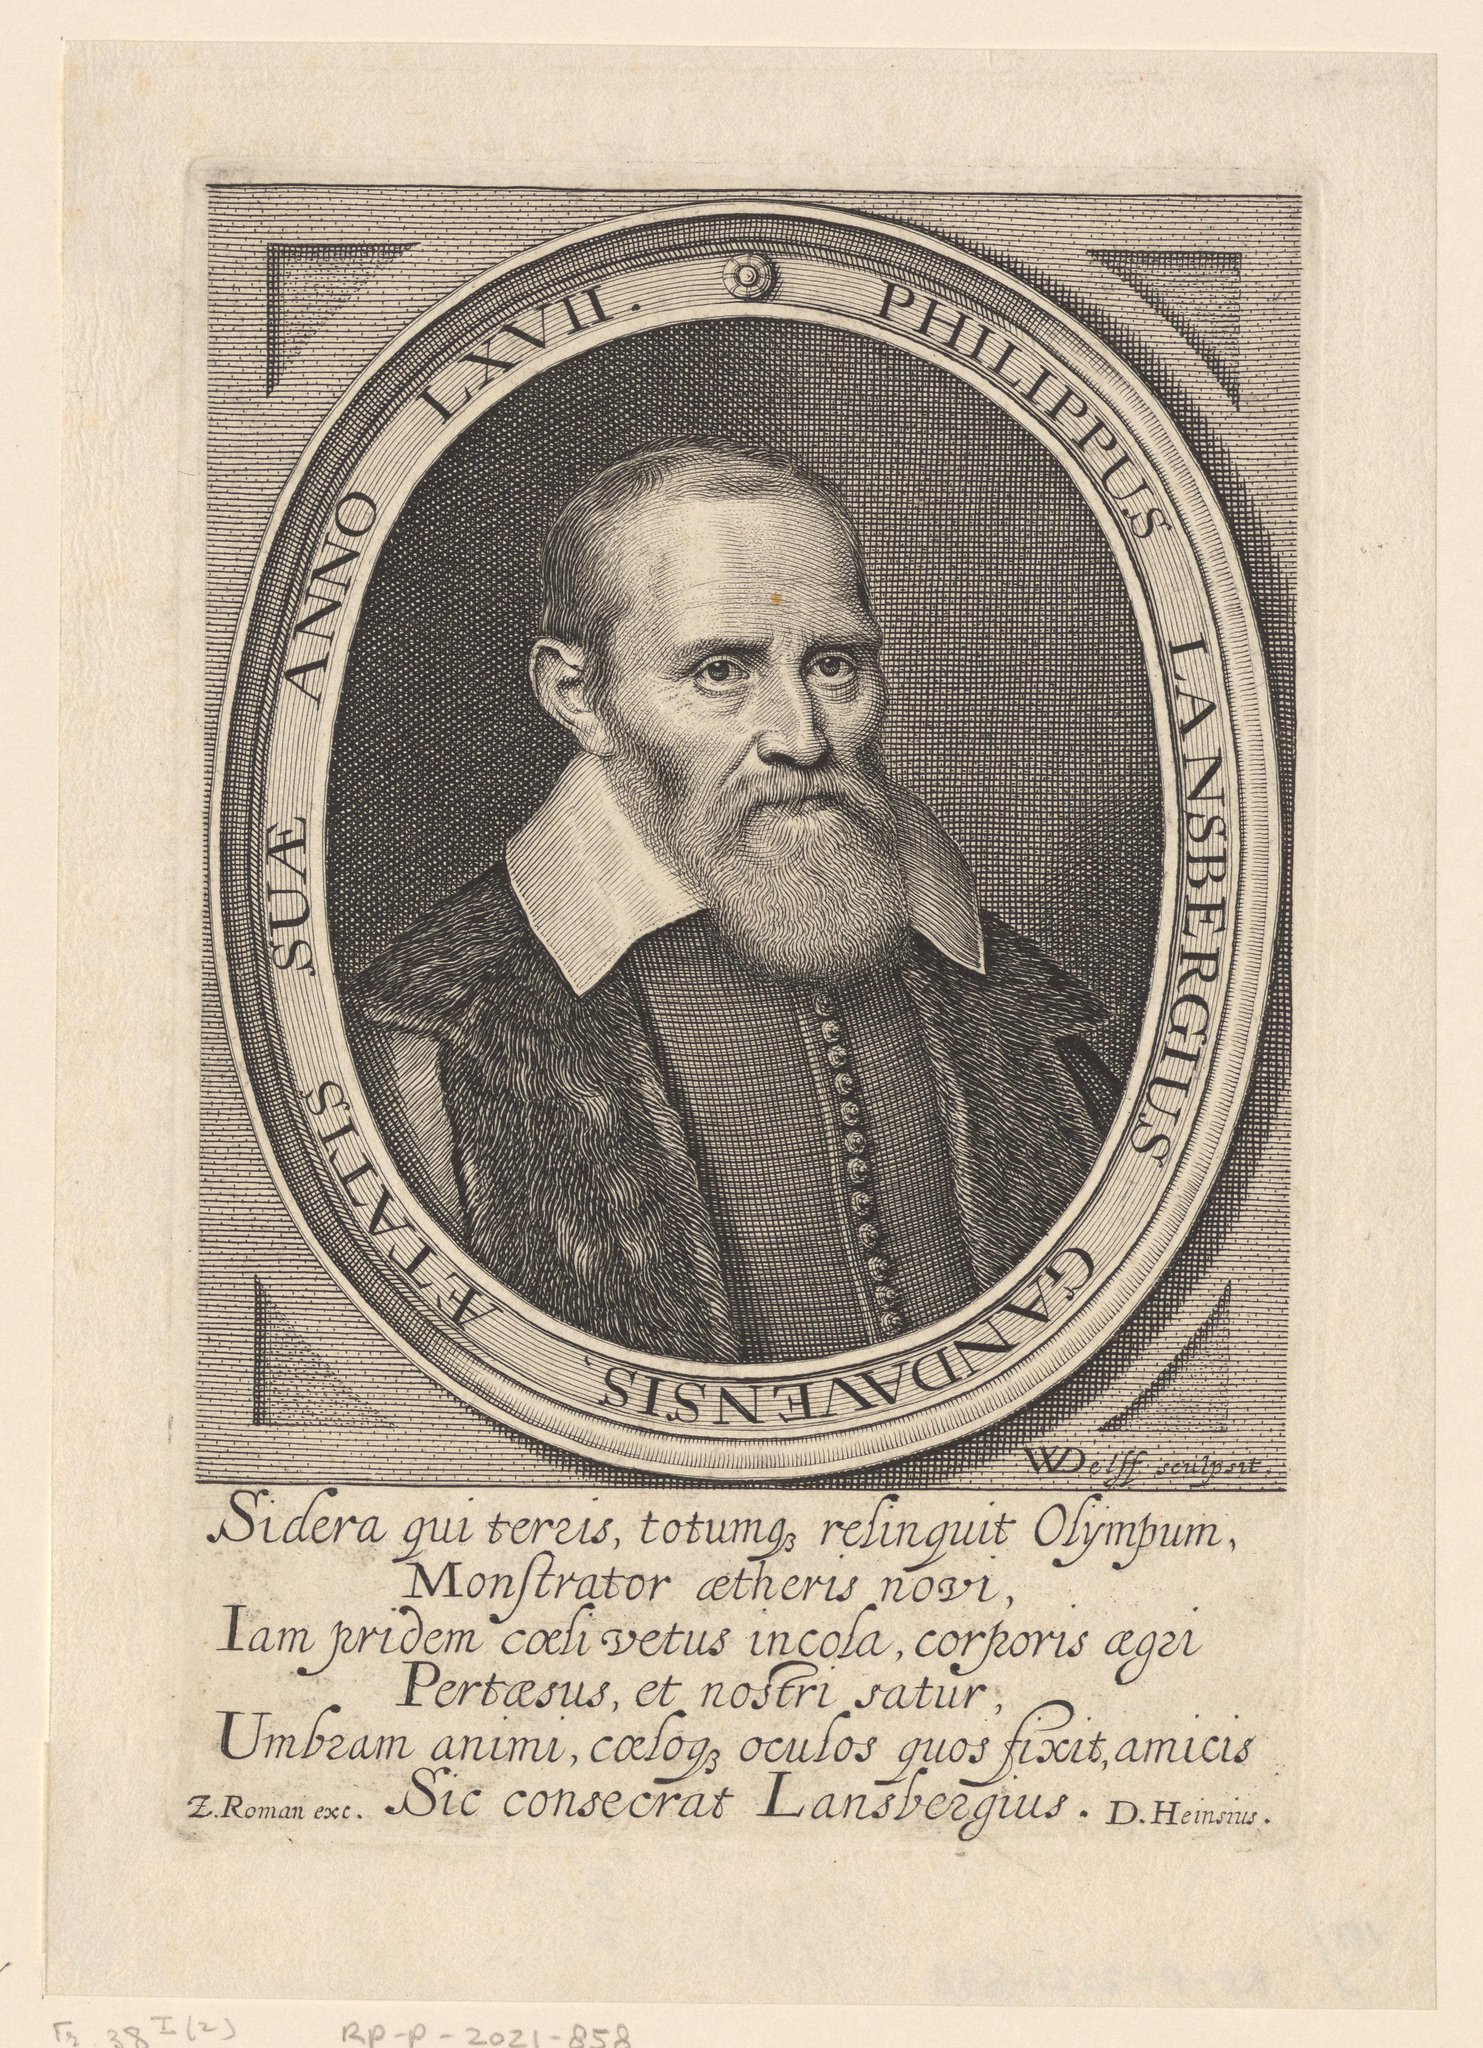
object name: print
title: Portret van Philippus Lansbergen op 67-jarige leeftijd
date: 1628-1638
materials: paper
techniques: engraving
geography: middelburg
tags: ghent, middelburg, physicist, philippus lansbergen, astronomy (and cosmography) (+ portrait of scholar, scientist), historical persons, portrait of a writer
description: Met zesregelig vers in het Latijn onder het portret.